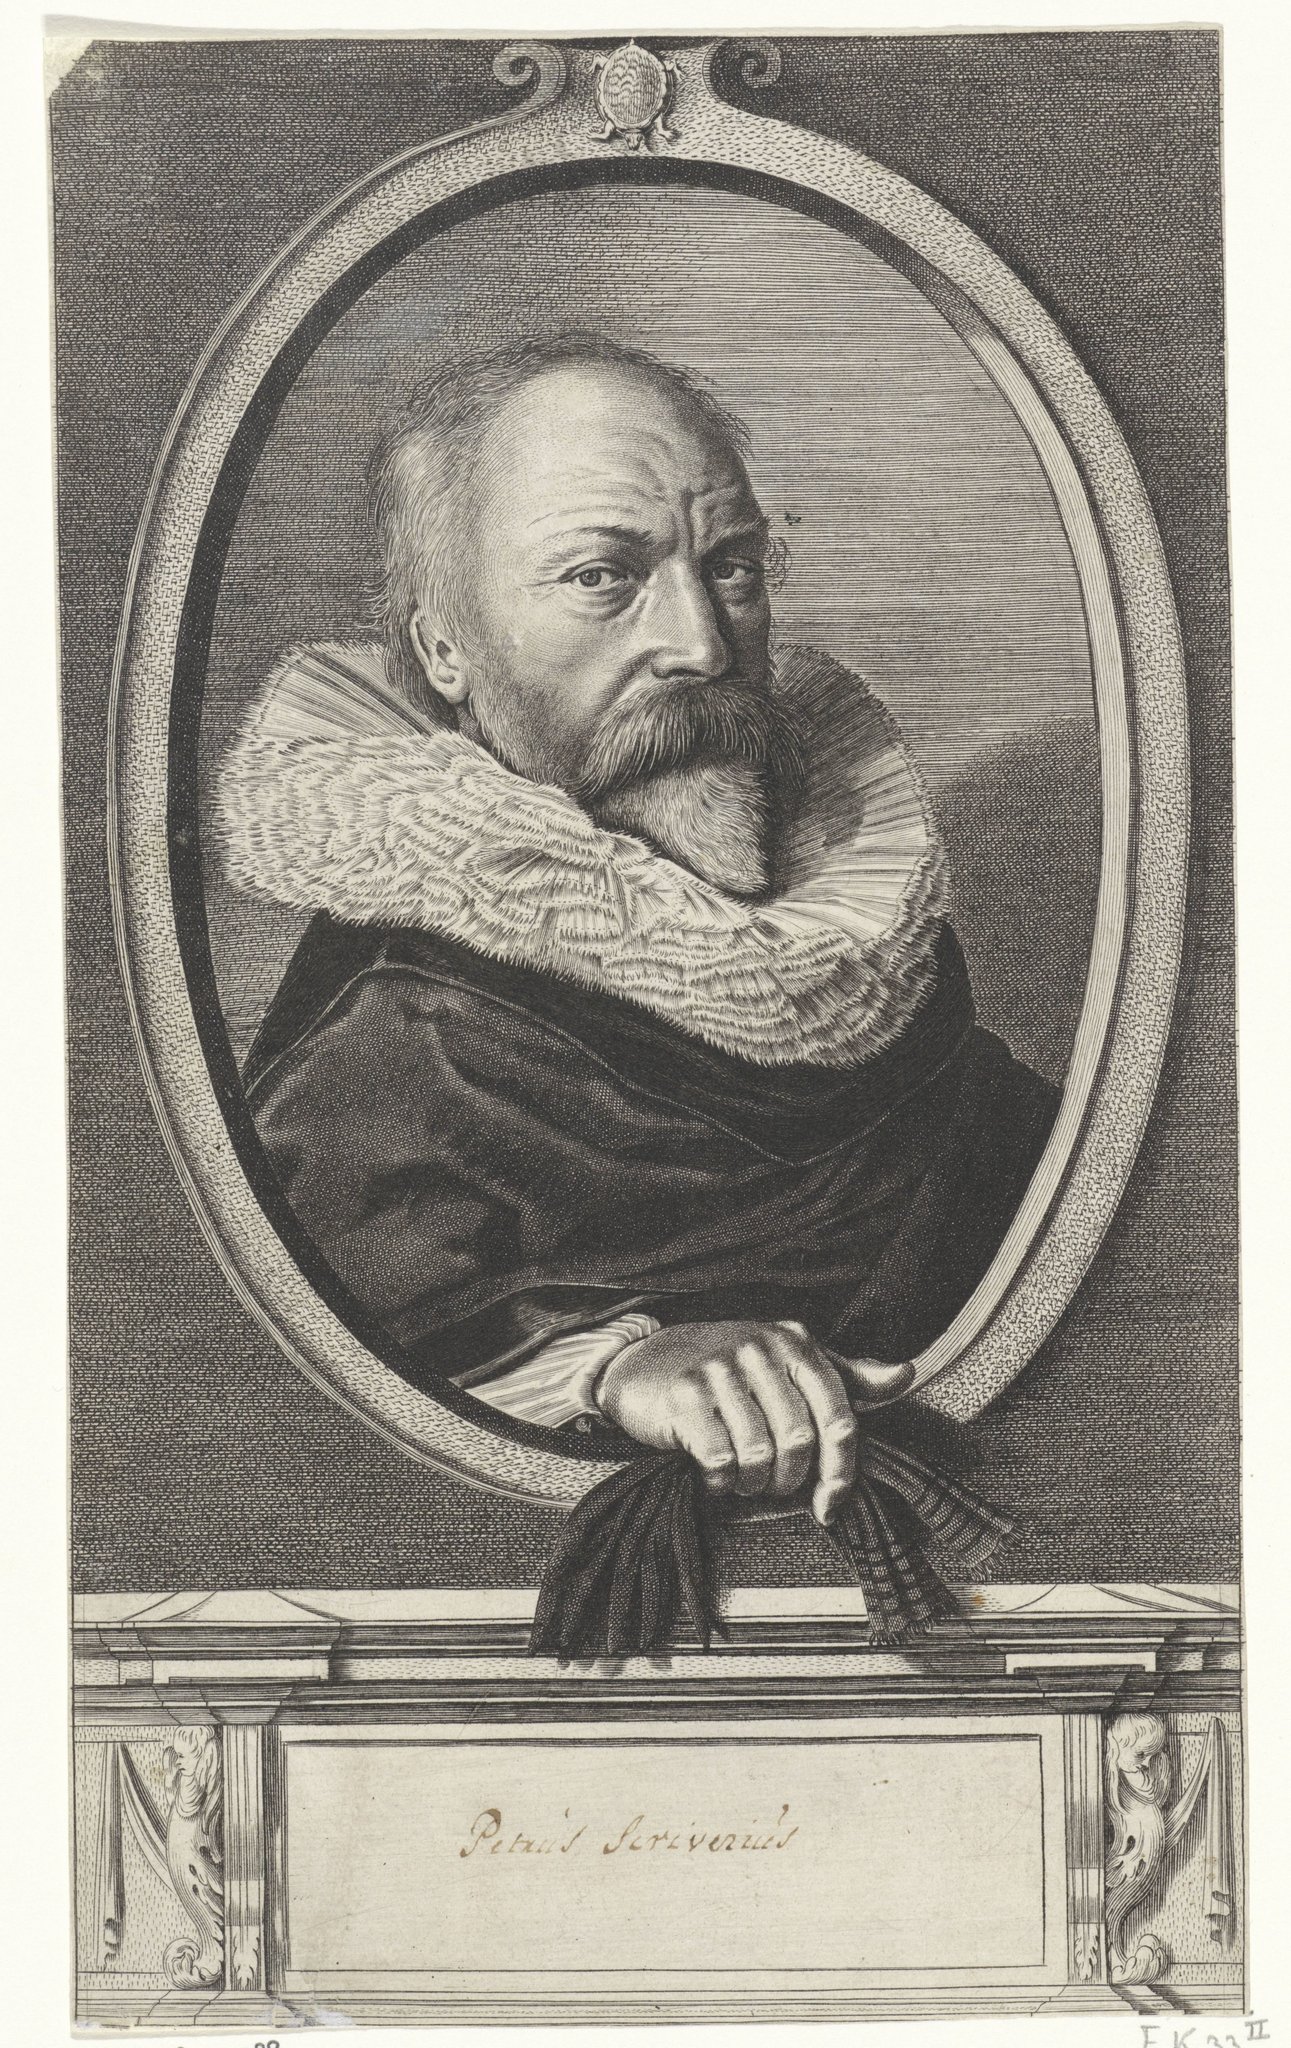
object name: print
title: Portret van Petrus Scriverius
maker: jan van de velde (ii)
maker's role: draughtsman, painter, print maker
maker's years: 1593-1641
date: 1626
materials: ink, paper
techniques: engraving, pen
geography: northern netherlands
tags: petrus scriverius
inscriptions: collector's mark: Lugt 240, name: ‘Petrus Scriverius’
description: Portret van de geschiedkundige en schrijver Petrus Scriverius.